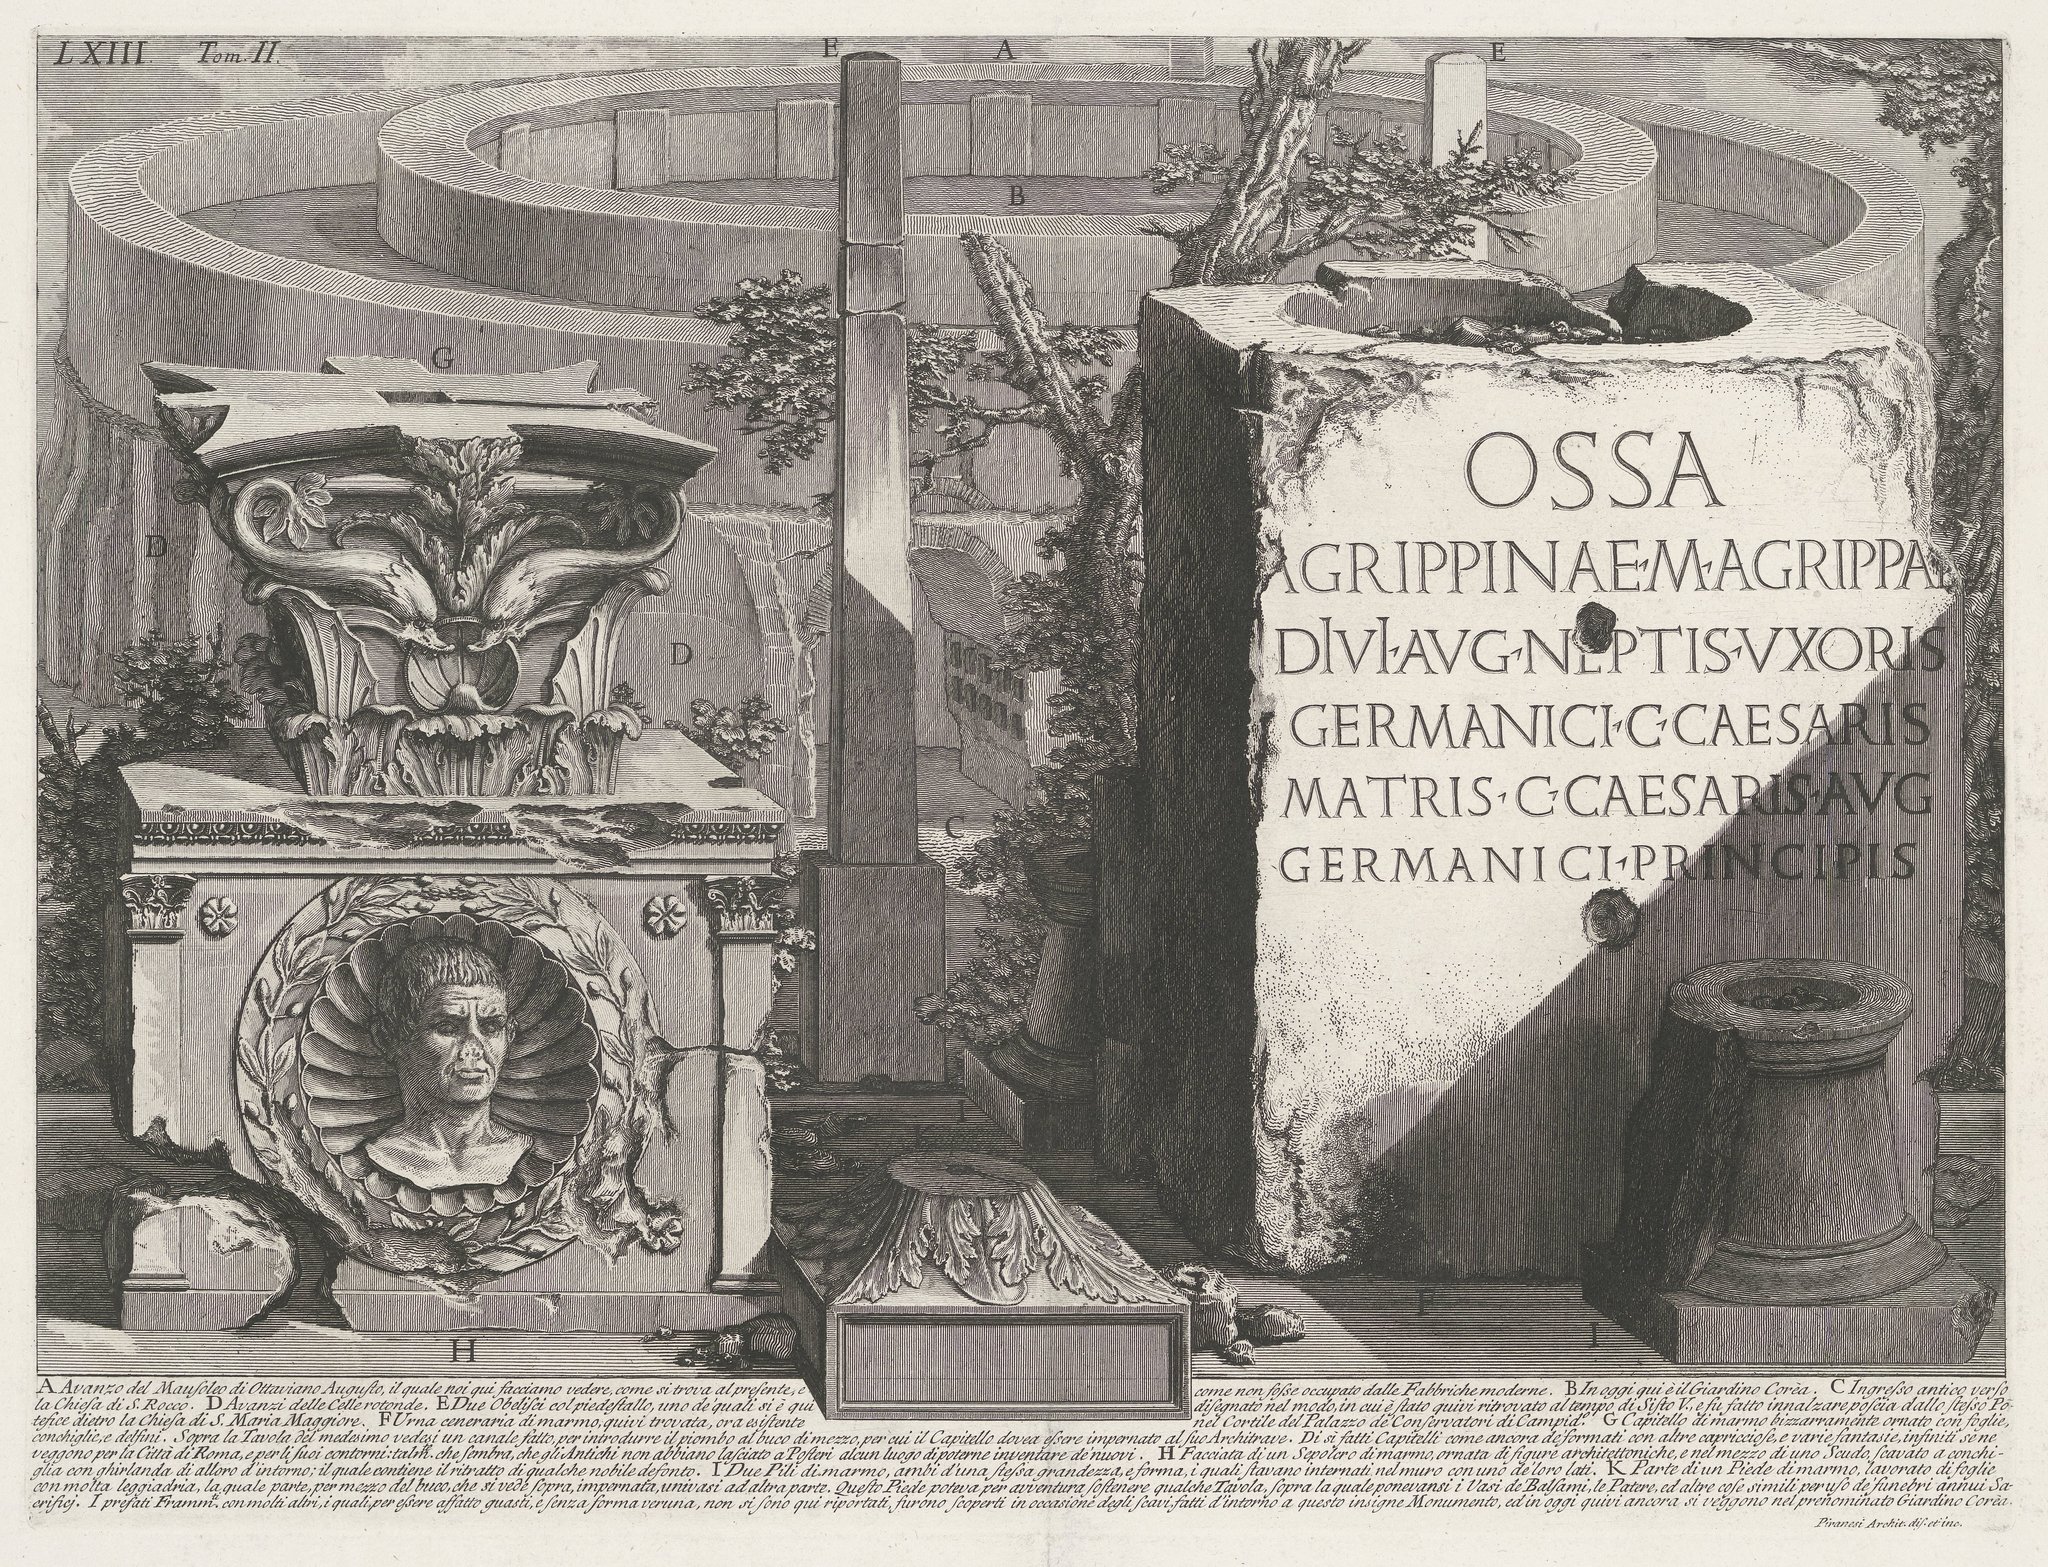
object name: print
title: Le Antichità Romane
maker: giovanni battista piranesi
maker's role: designer, draughtsman, print maker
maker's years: 1720-1778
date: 1756-1757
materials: paper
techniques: etching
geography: rome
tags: altar ~ non-christian religions, ruin of a building ~ architecture, capital (~ column, pillar), base (~ column, pillar), rome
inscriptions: collector's mark: Lugt 2228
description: Deze prent maakt deel uit van de serie 'Le Antichità Romane'. Piranesi deed meer dan acht jaar voorstudie voor deze 250 platen tellende serie die in vier volumes werd uitgegeven. Hij produceerde de prenten tussen ca. 1756 en 1757. De serie bevat ook prenten door of naar andere prentmakers, onder wie Francesco Bianchini en Girolamo Rossi.